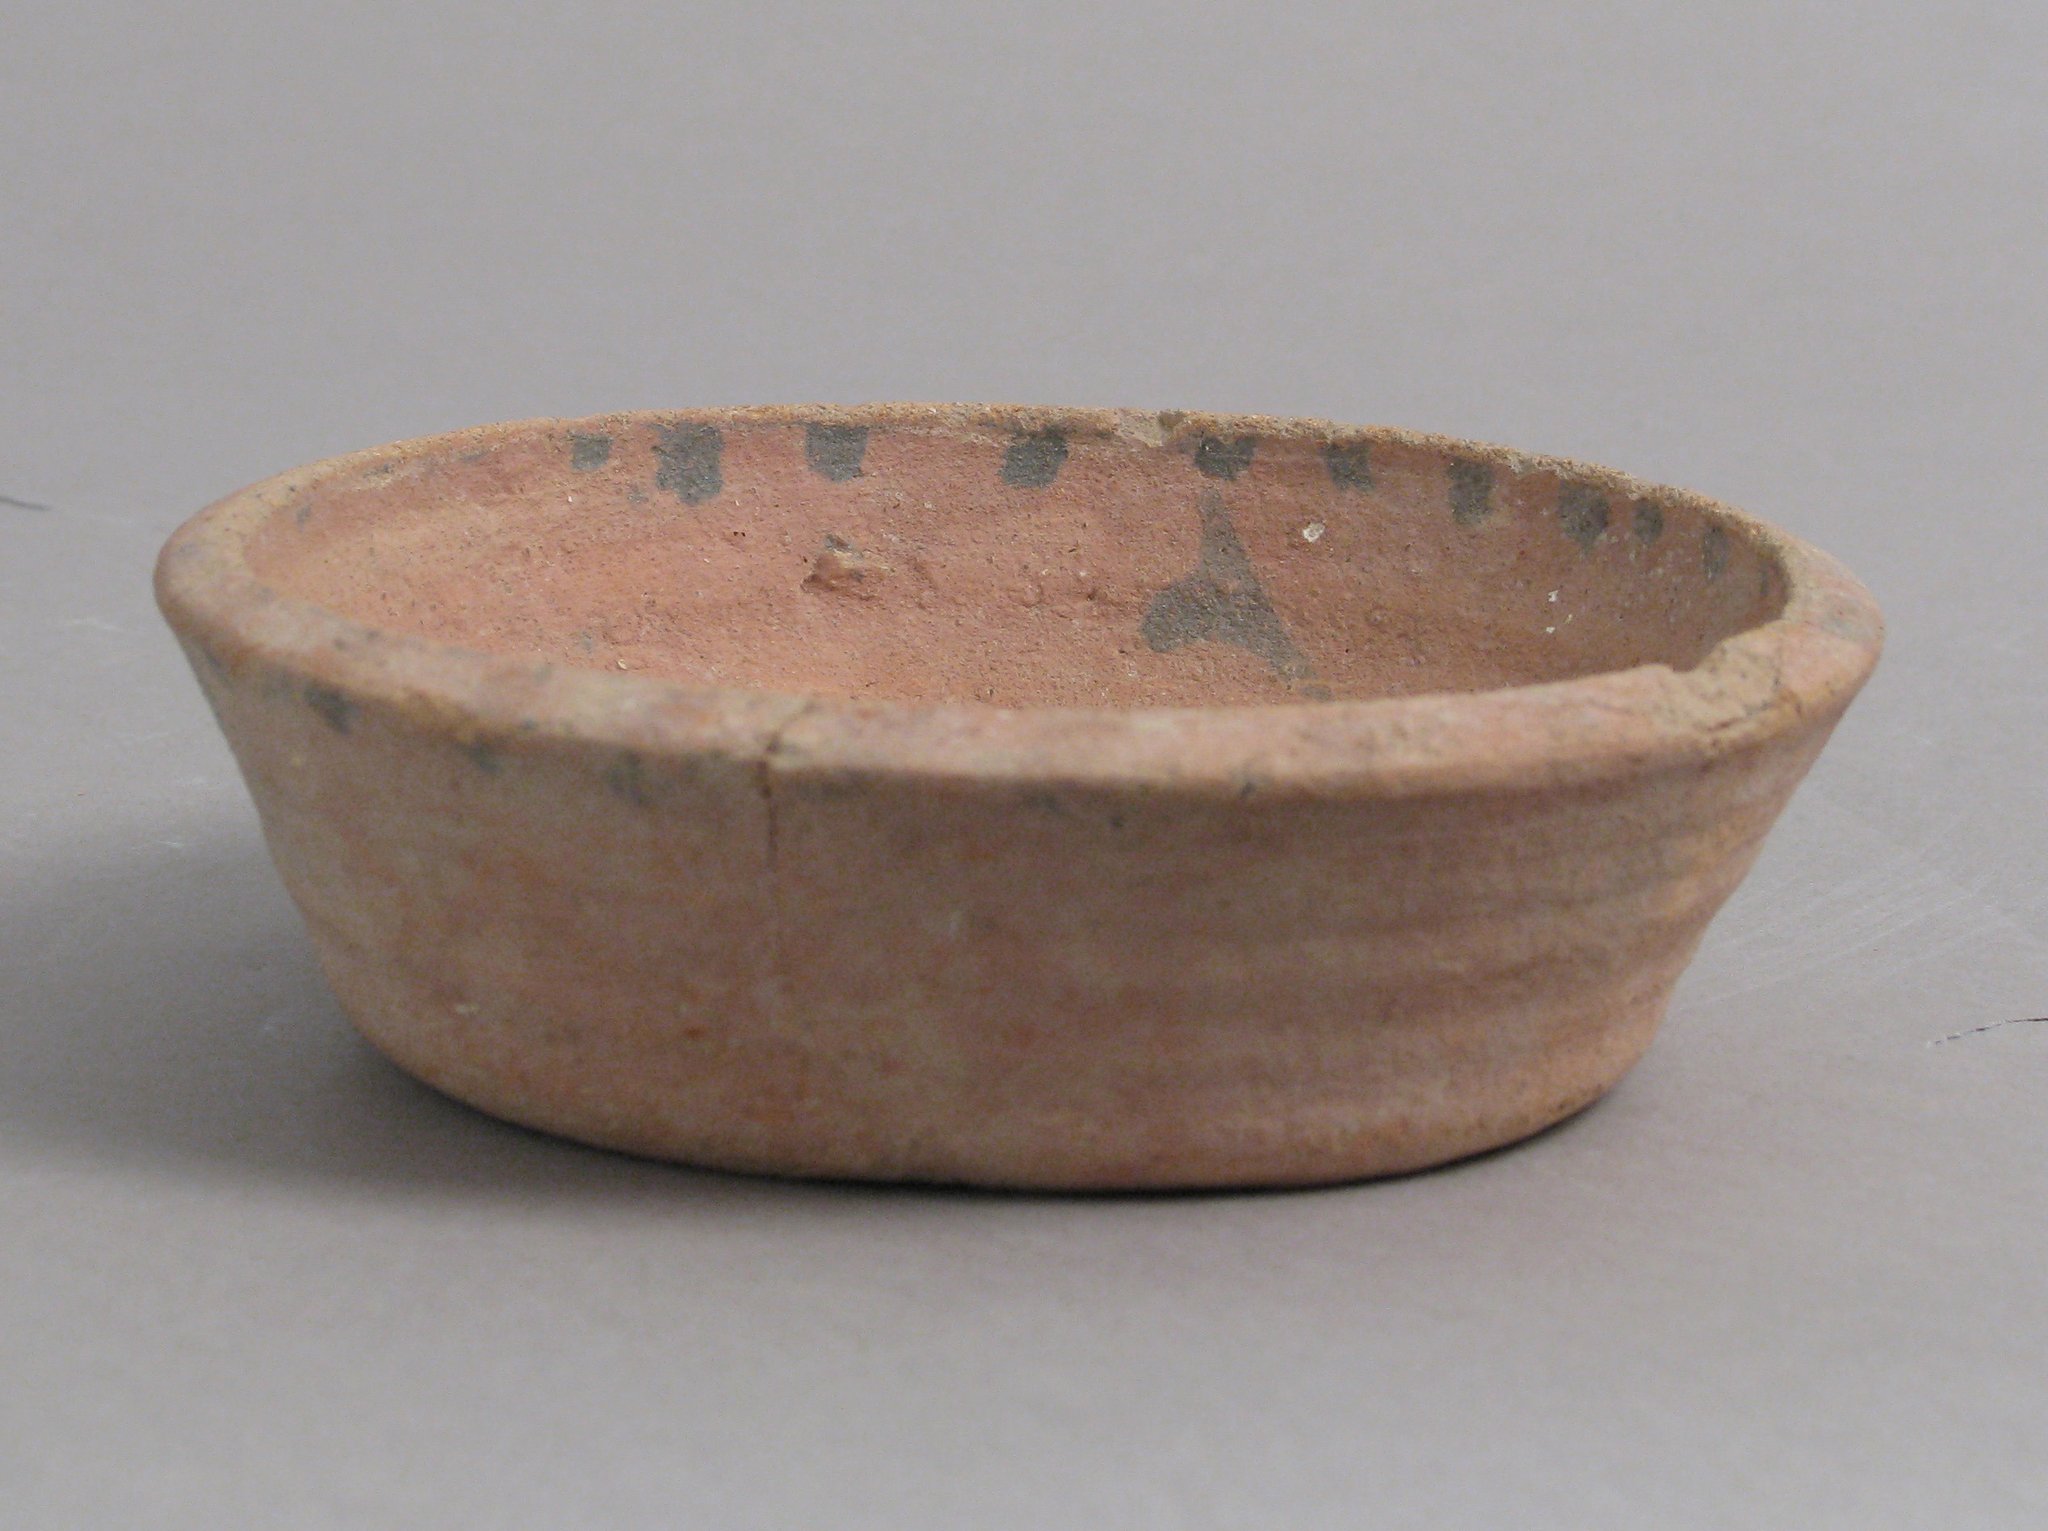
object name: bowl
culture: coptic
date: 301-700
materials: earthenware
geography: egypt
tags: bowls